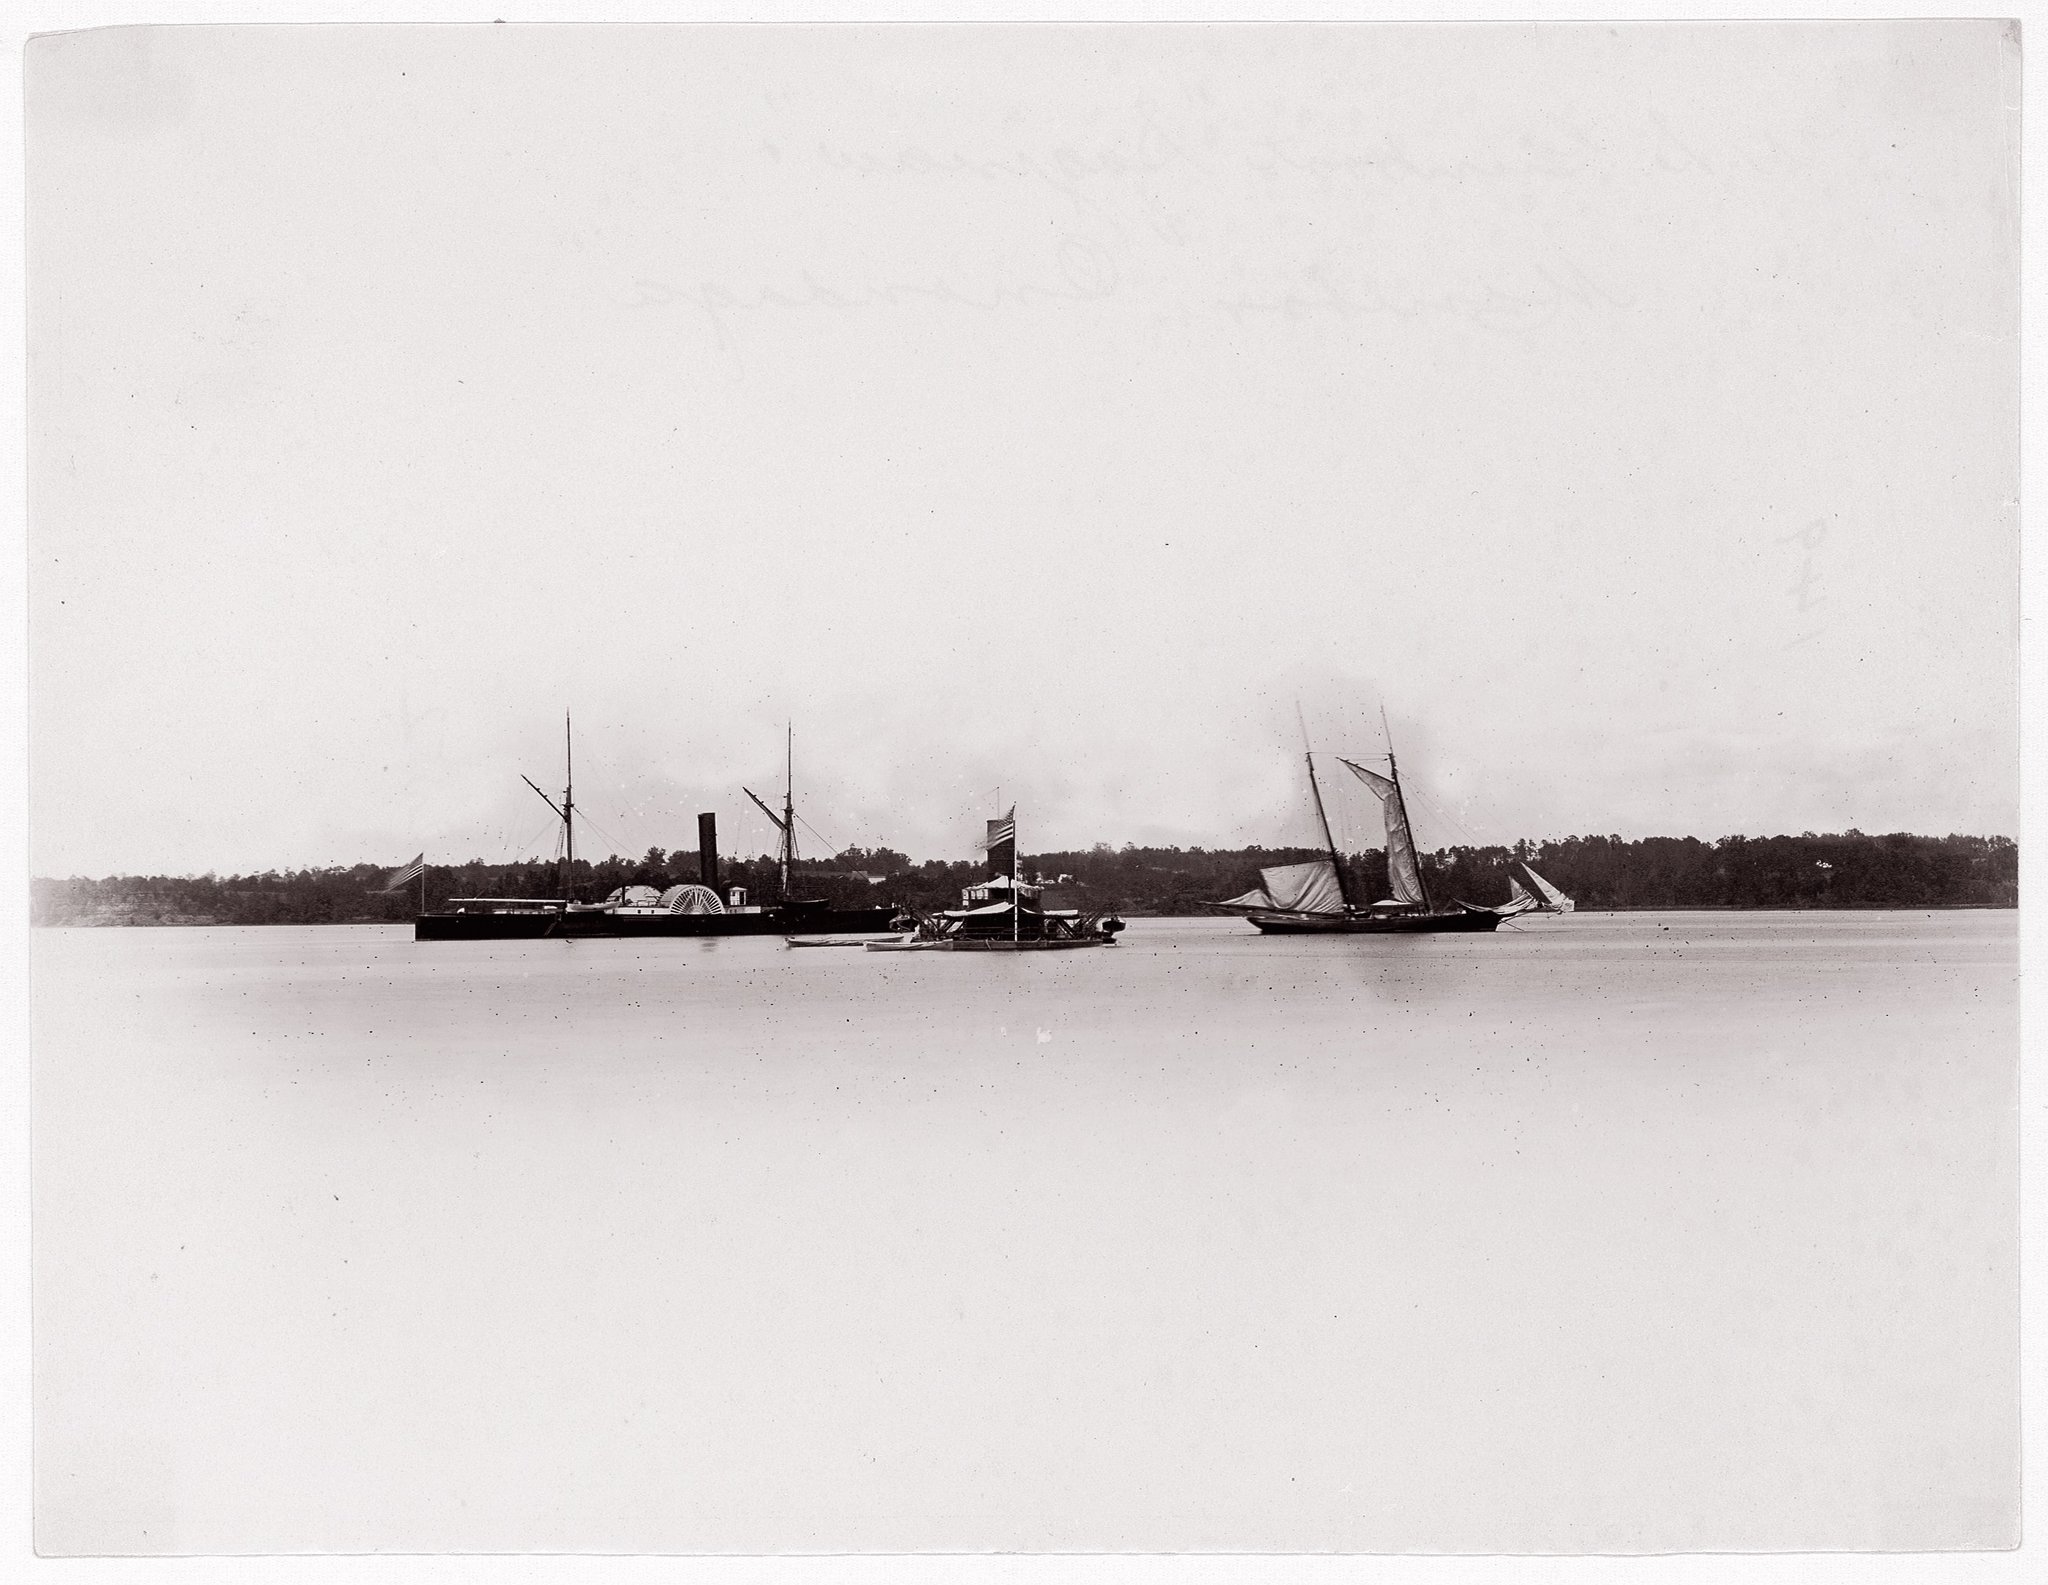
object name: photograph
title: [U.S.S. Onondaga on James River, Virginia]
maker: Anonymous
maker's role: artist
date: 1864-1865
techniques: albumen silver print, glass negative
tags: american civil war,ships